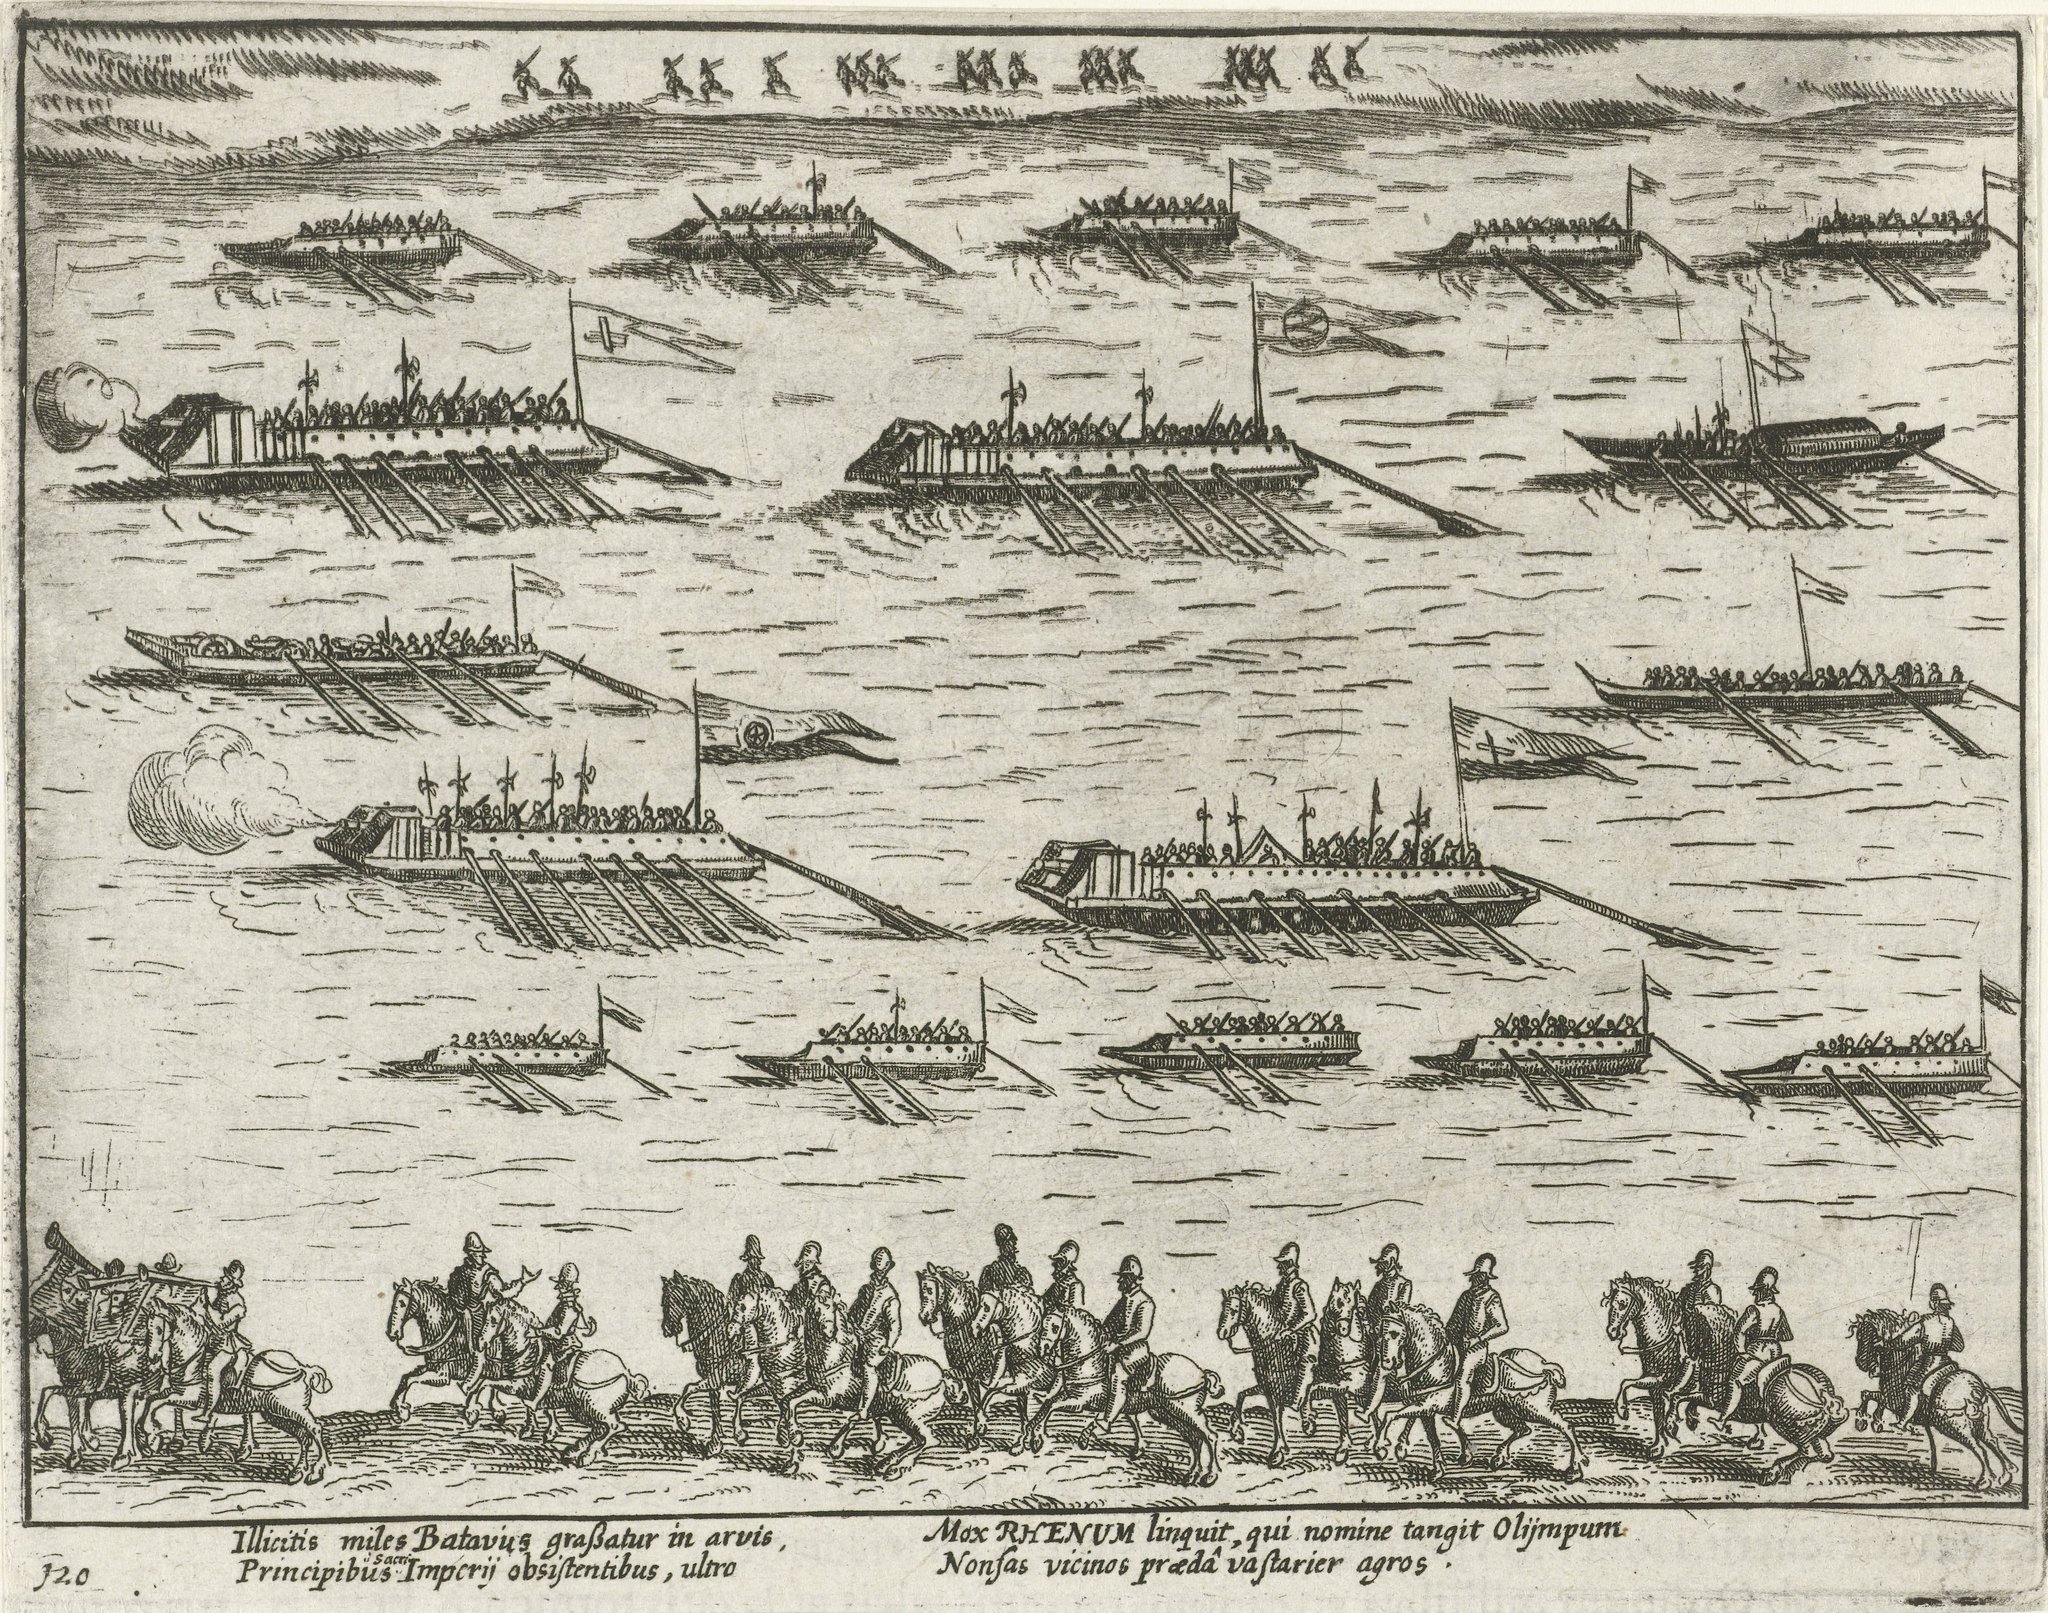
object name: print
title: Vloot van de vier keurvorsten op de Rijn, 1580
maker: Anonymous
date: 1613-1615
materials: paper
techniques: etching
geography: northern netherlands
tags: warfare; military affairs (+ oared ships, e.g.: galley)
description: Vloot van bewapende galeien en roeivaartuigen van de vier Duitse keurvorsten op de Rijn, ruiters op de oever. Met onderschrift van 4 regels in het Latijn. Genummerd 120. Bedrukt op achterzijde met tekst in het Latijn.